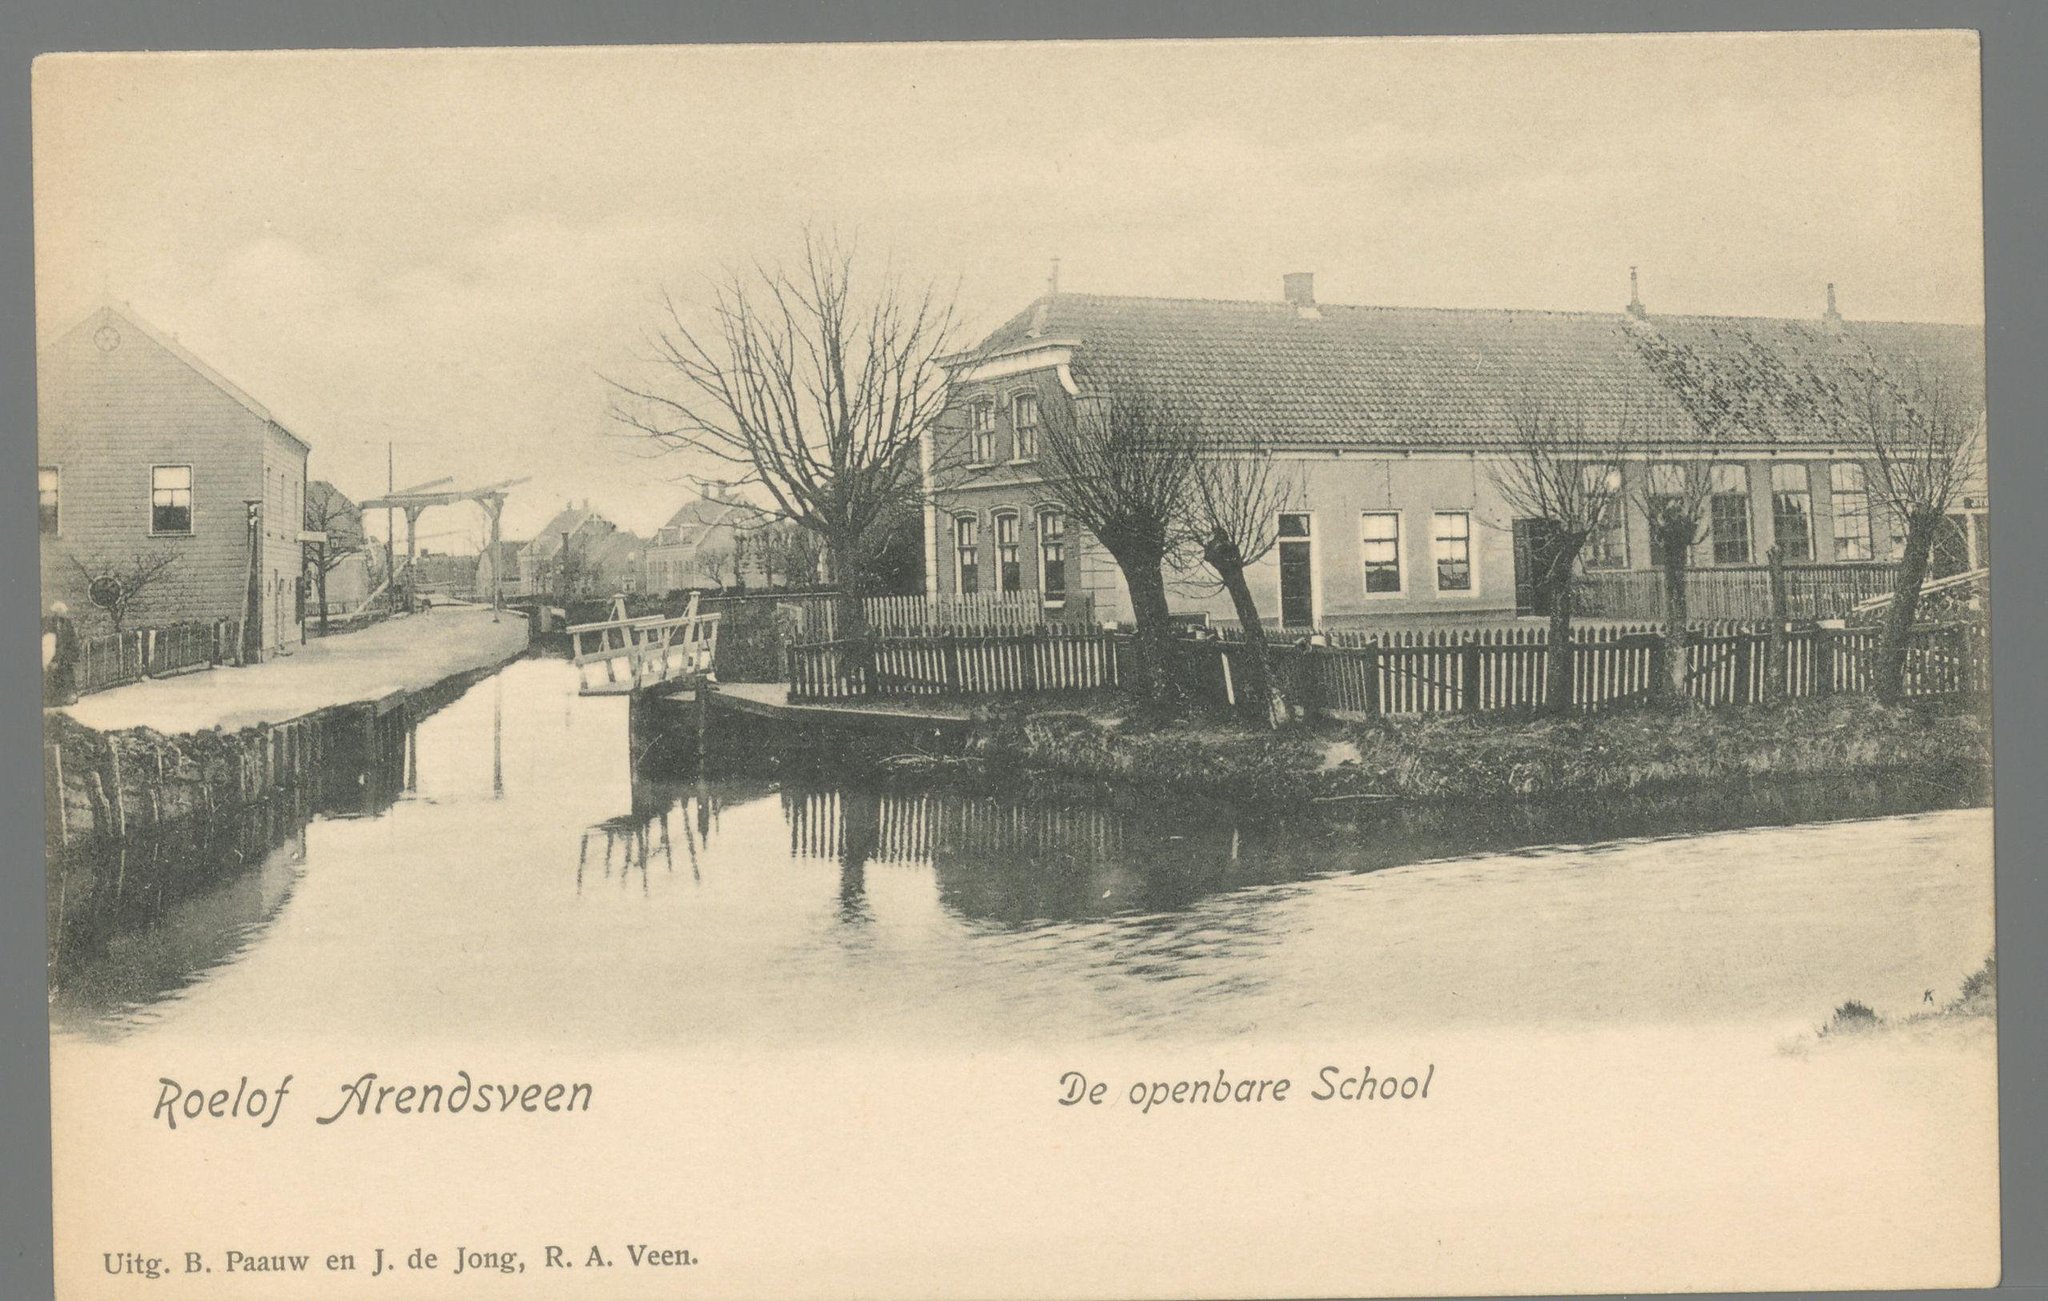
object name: ansichtkaart, prentbriefkaart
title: Roelof Arendsveen. De openbare school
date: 1897-1905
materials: cardboard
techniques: photograph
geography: roelofarendsveen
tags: city-view, and landscape with man-made constructions, bridge in city across river, canal, etc., elementary school; class, form